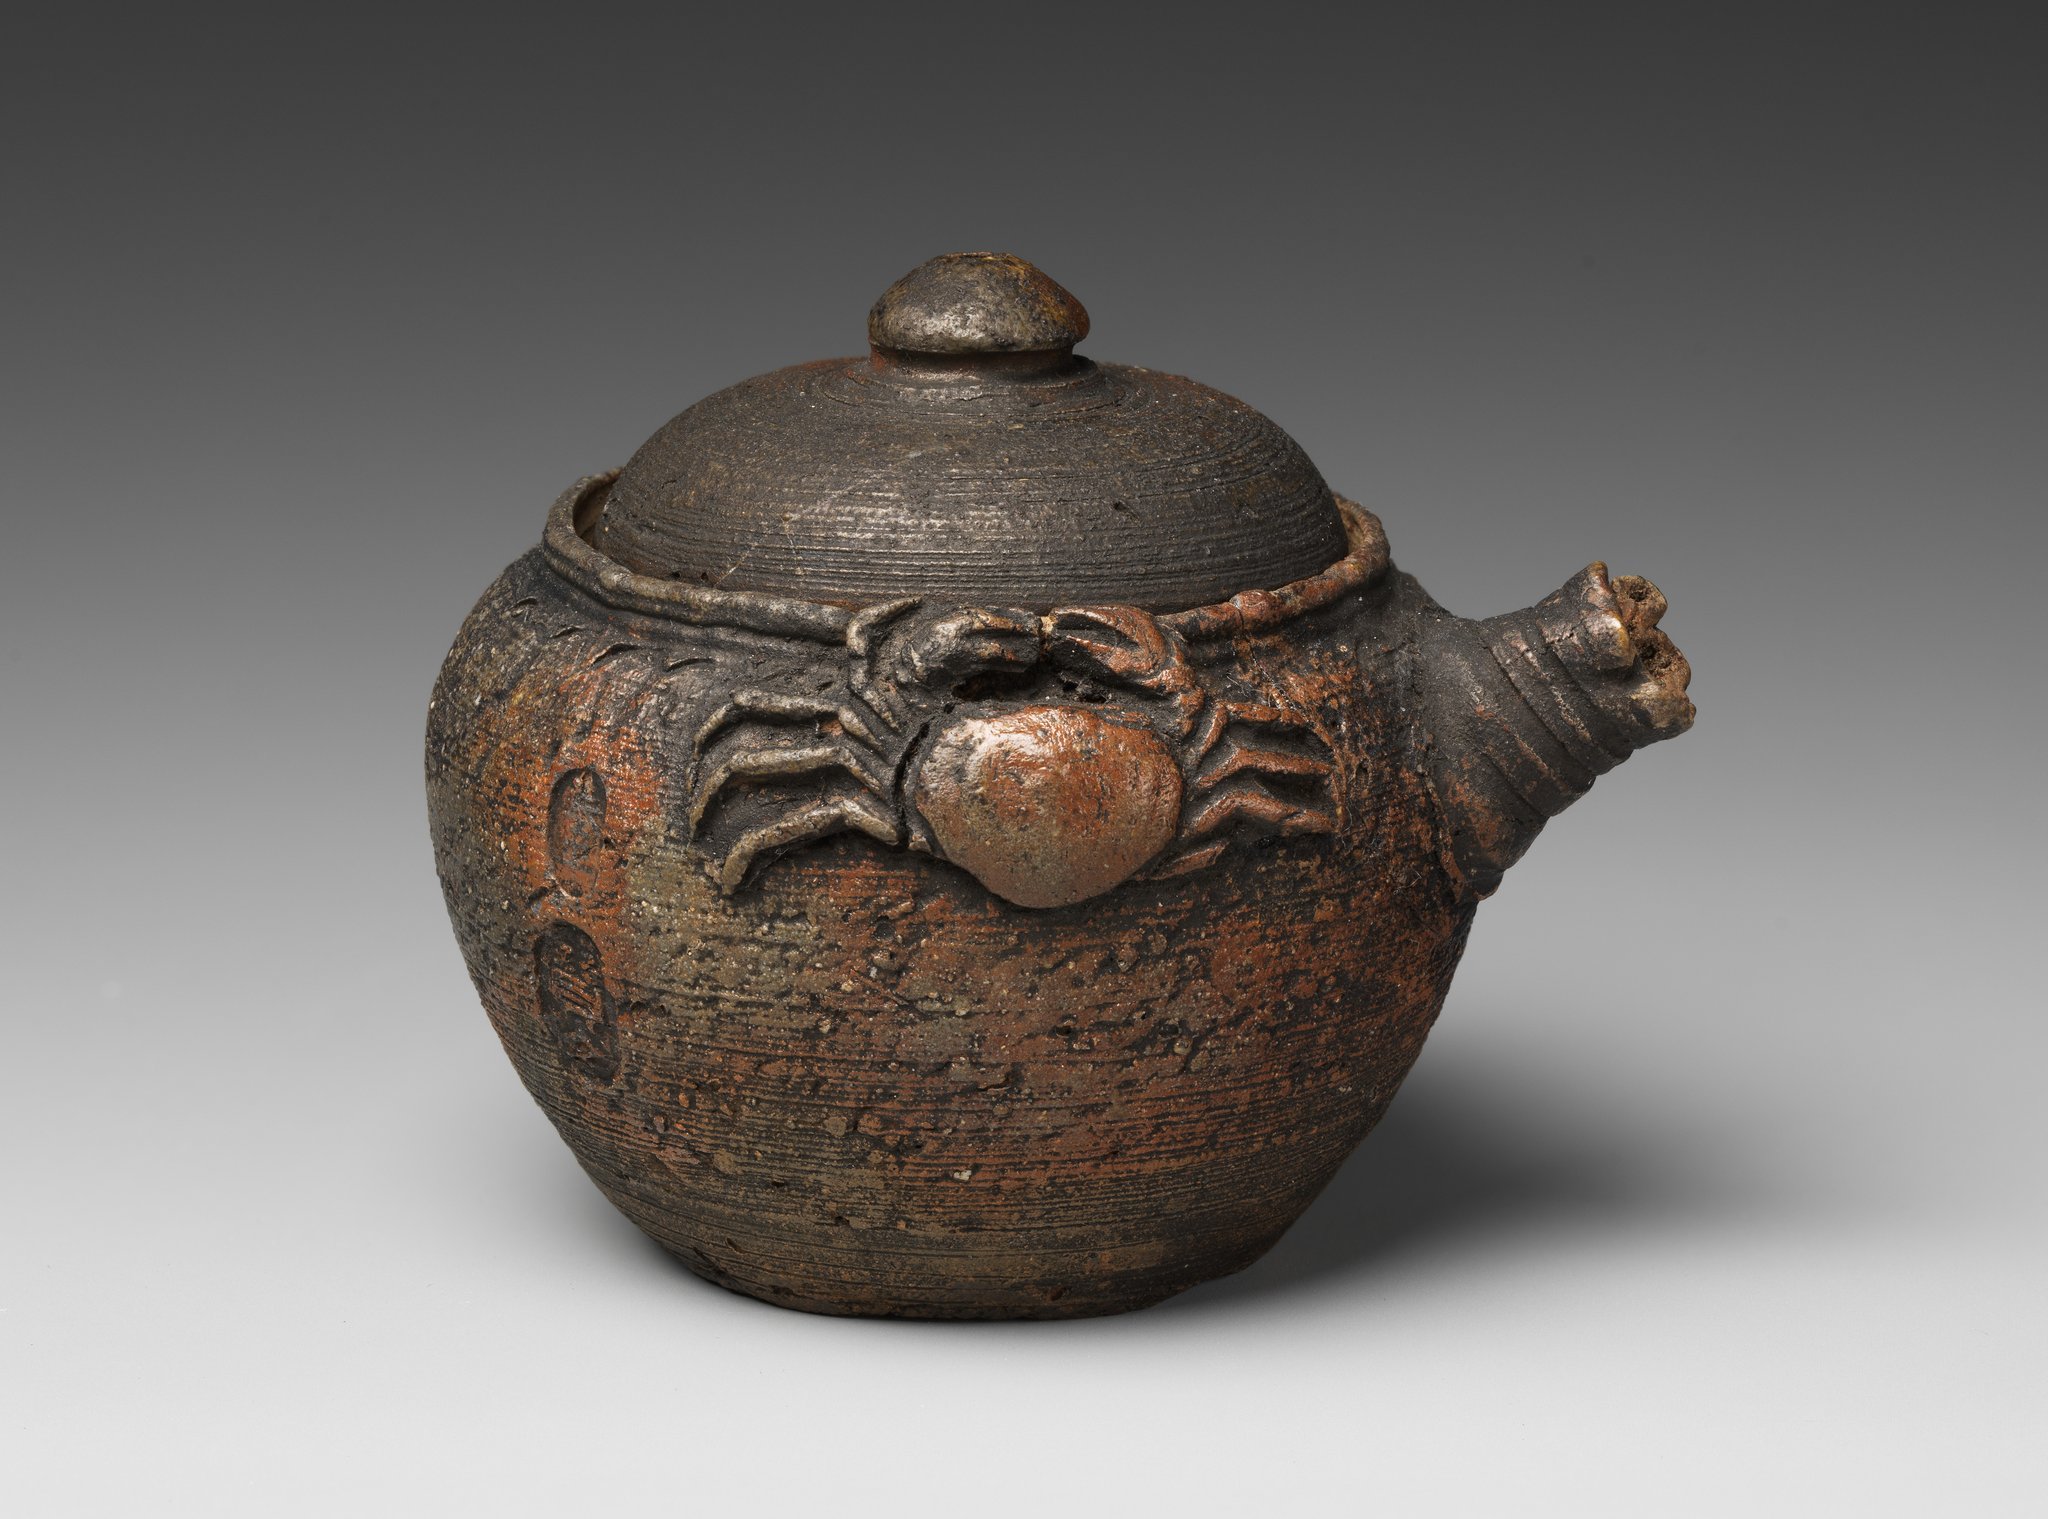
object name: teapot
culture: japanese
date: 1801-1900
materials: glaze, pottery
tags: crabs